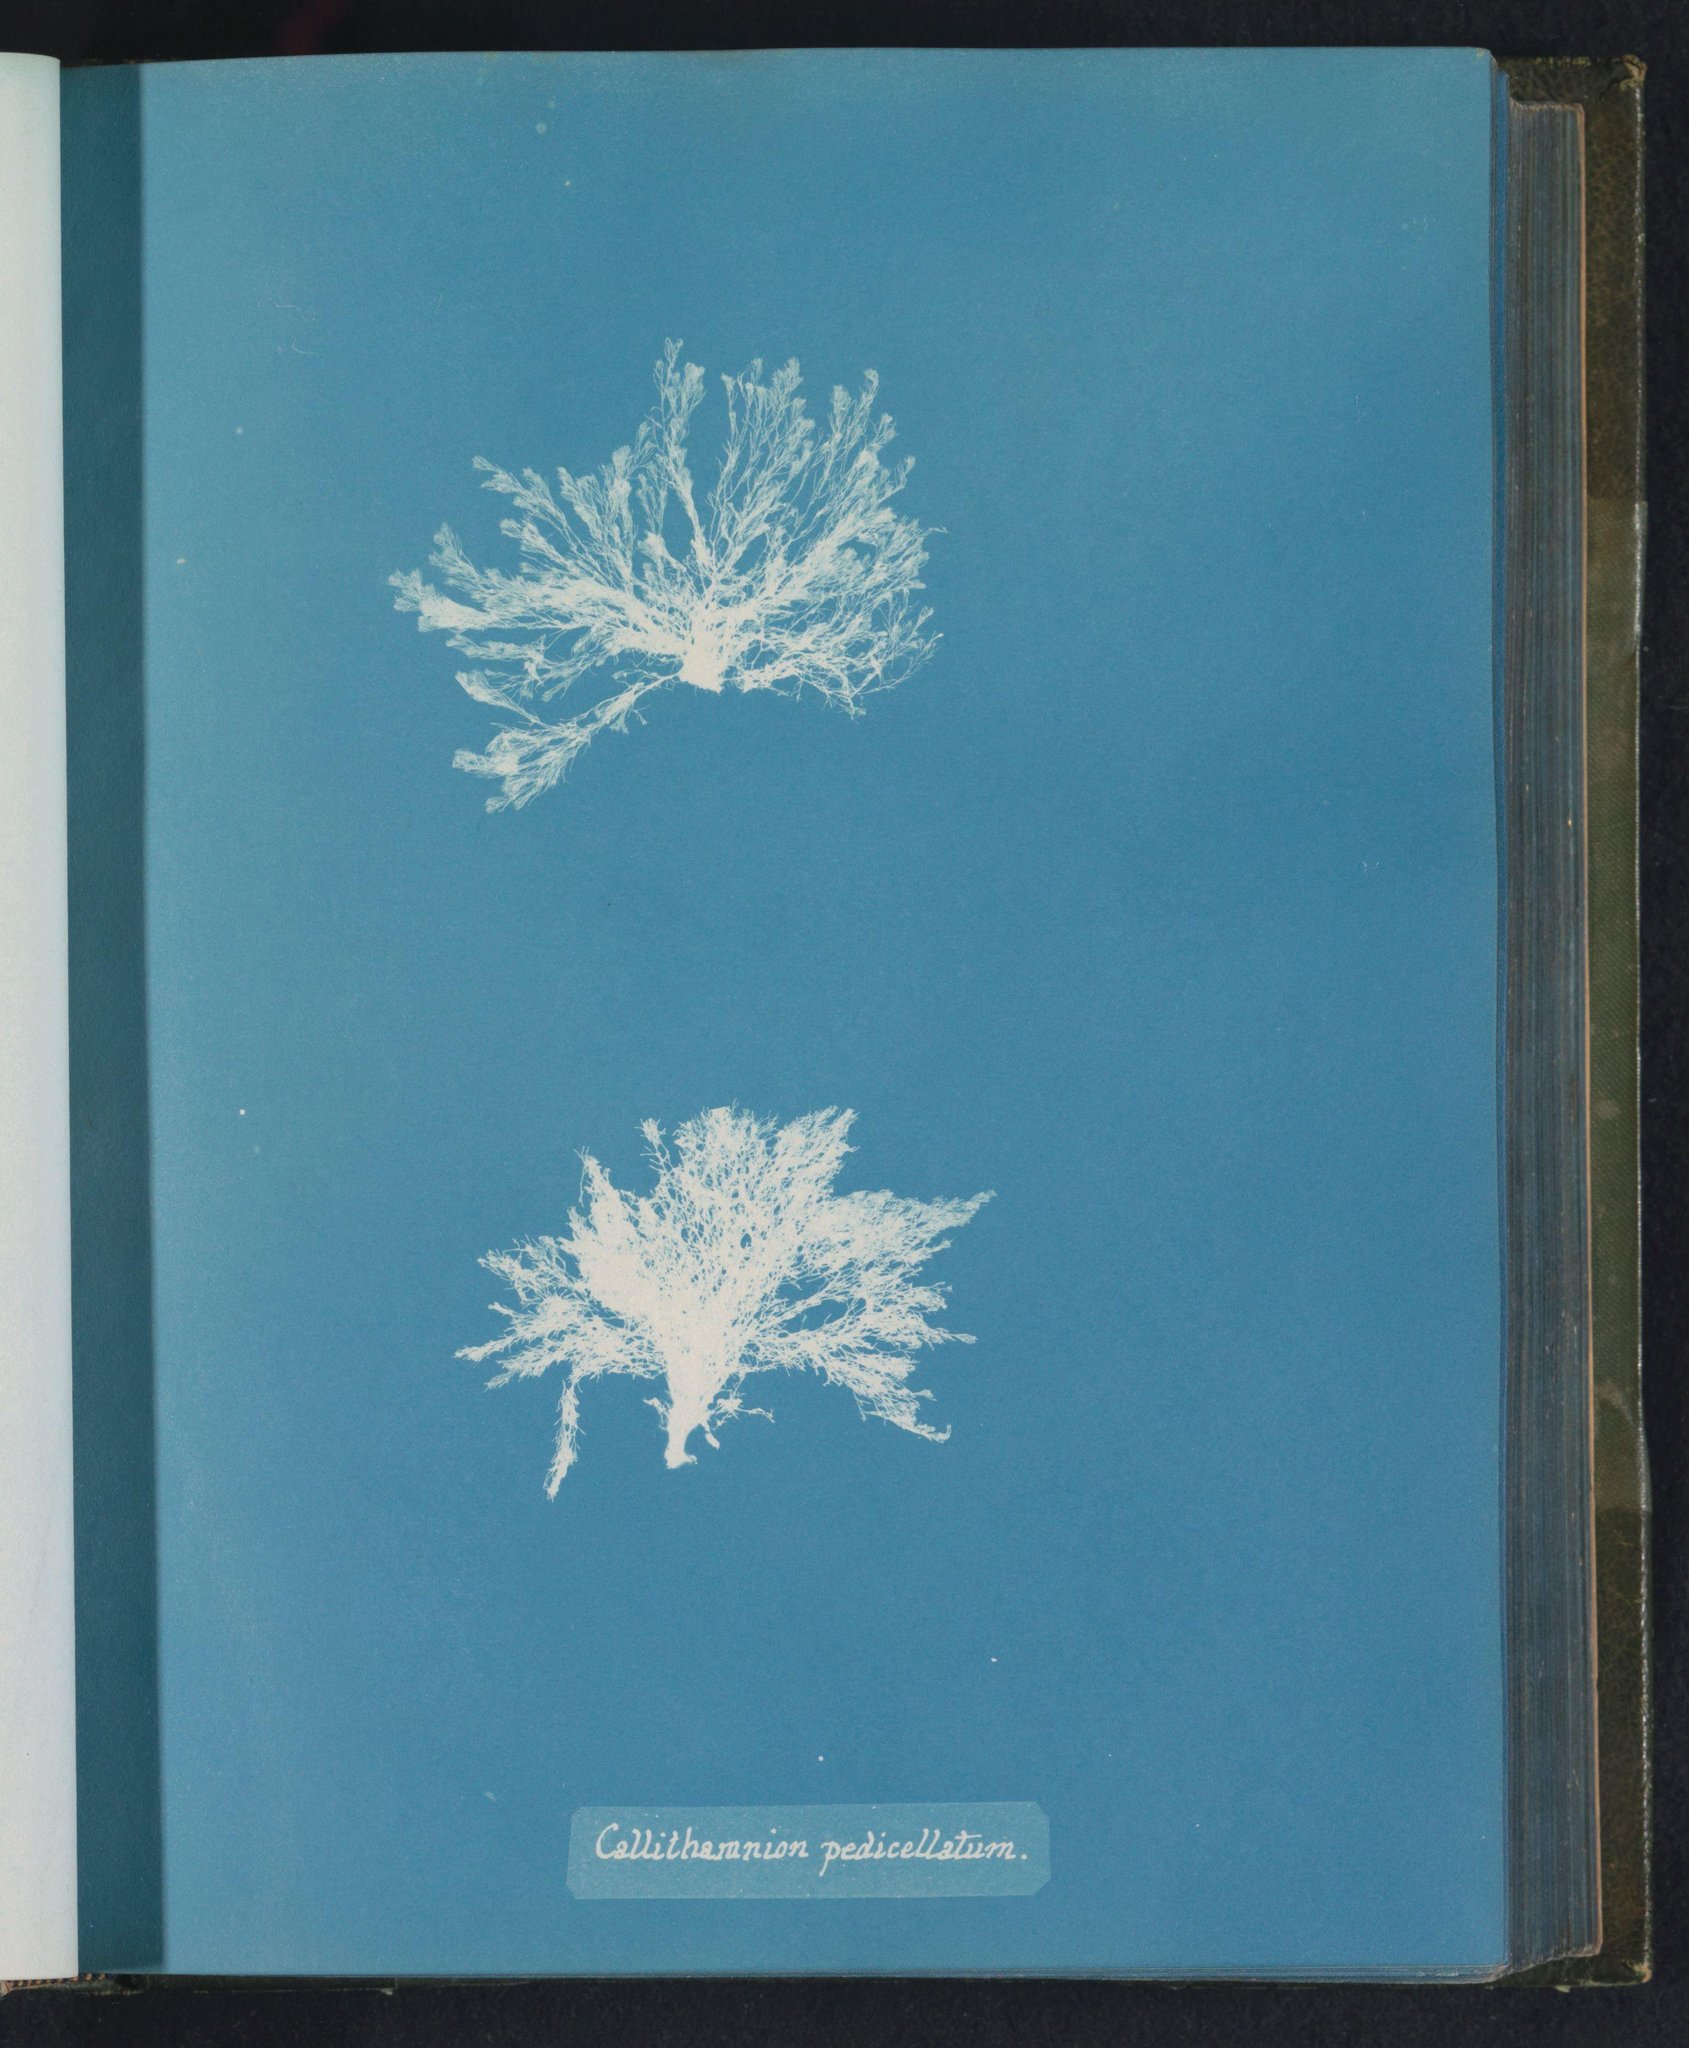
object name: photograph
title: Zeewier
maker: anna atkins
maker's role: fotograaf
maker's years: 1799-1871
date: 1843-1853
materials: photographic support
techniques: cyanotype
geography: united kingdom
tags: algae, seaweed